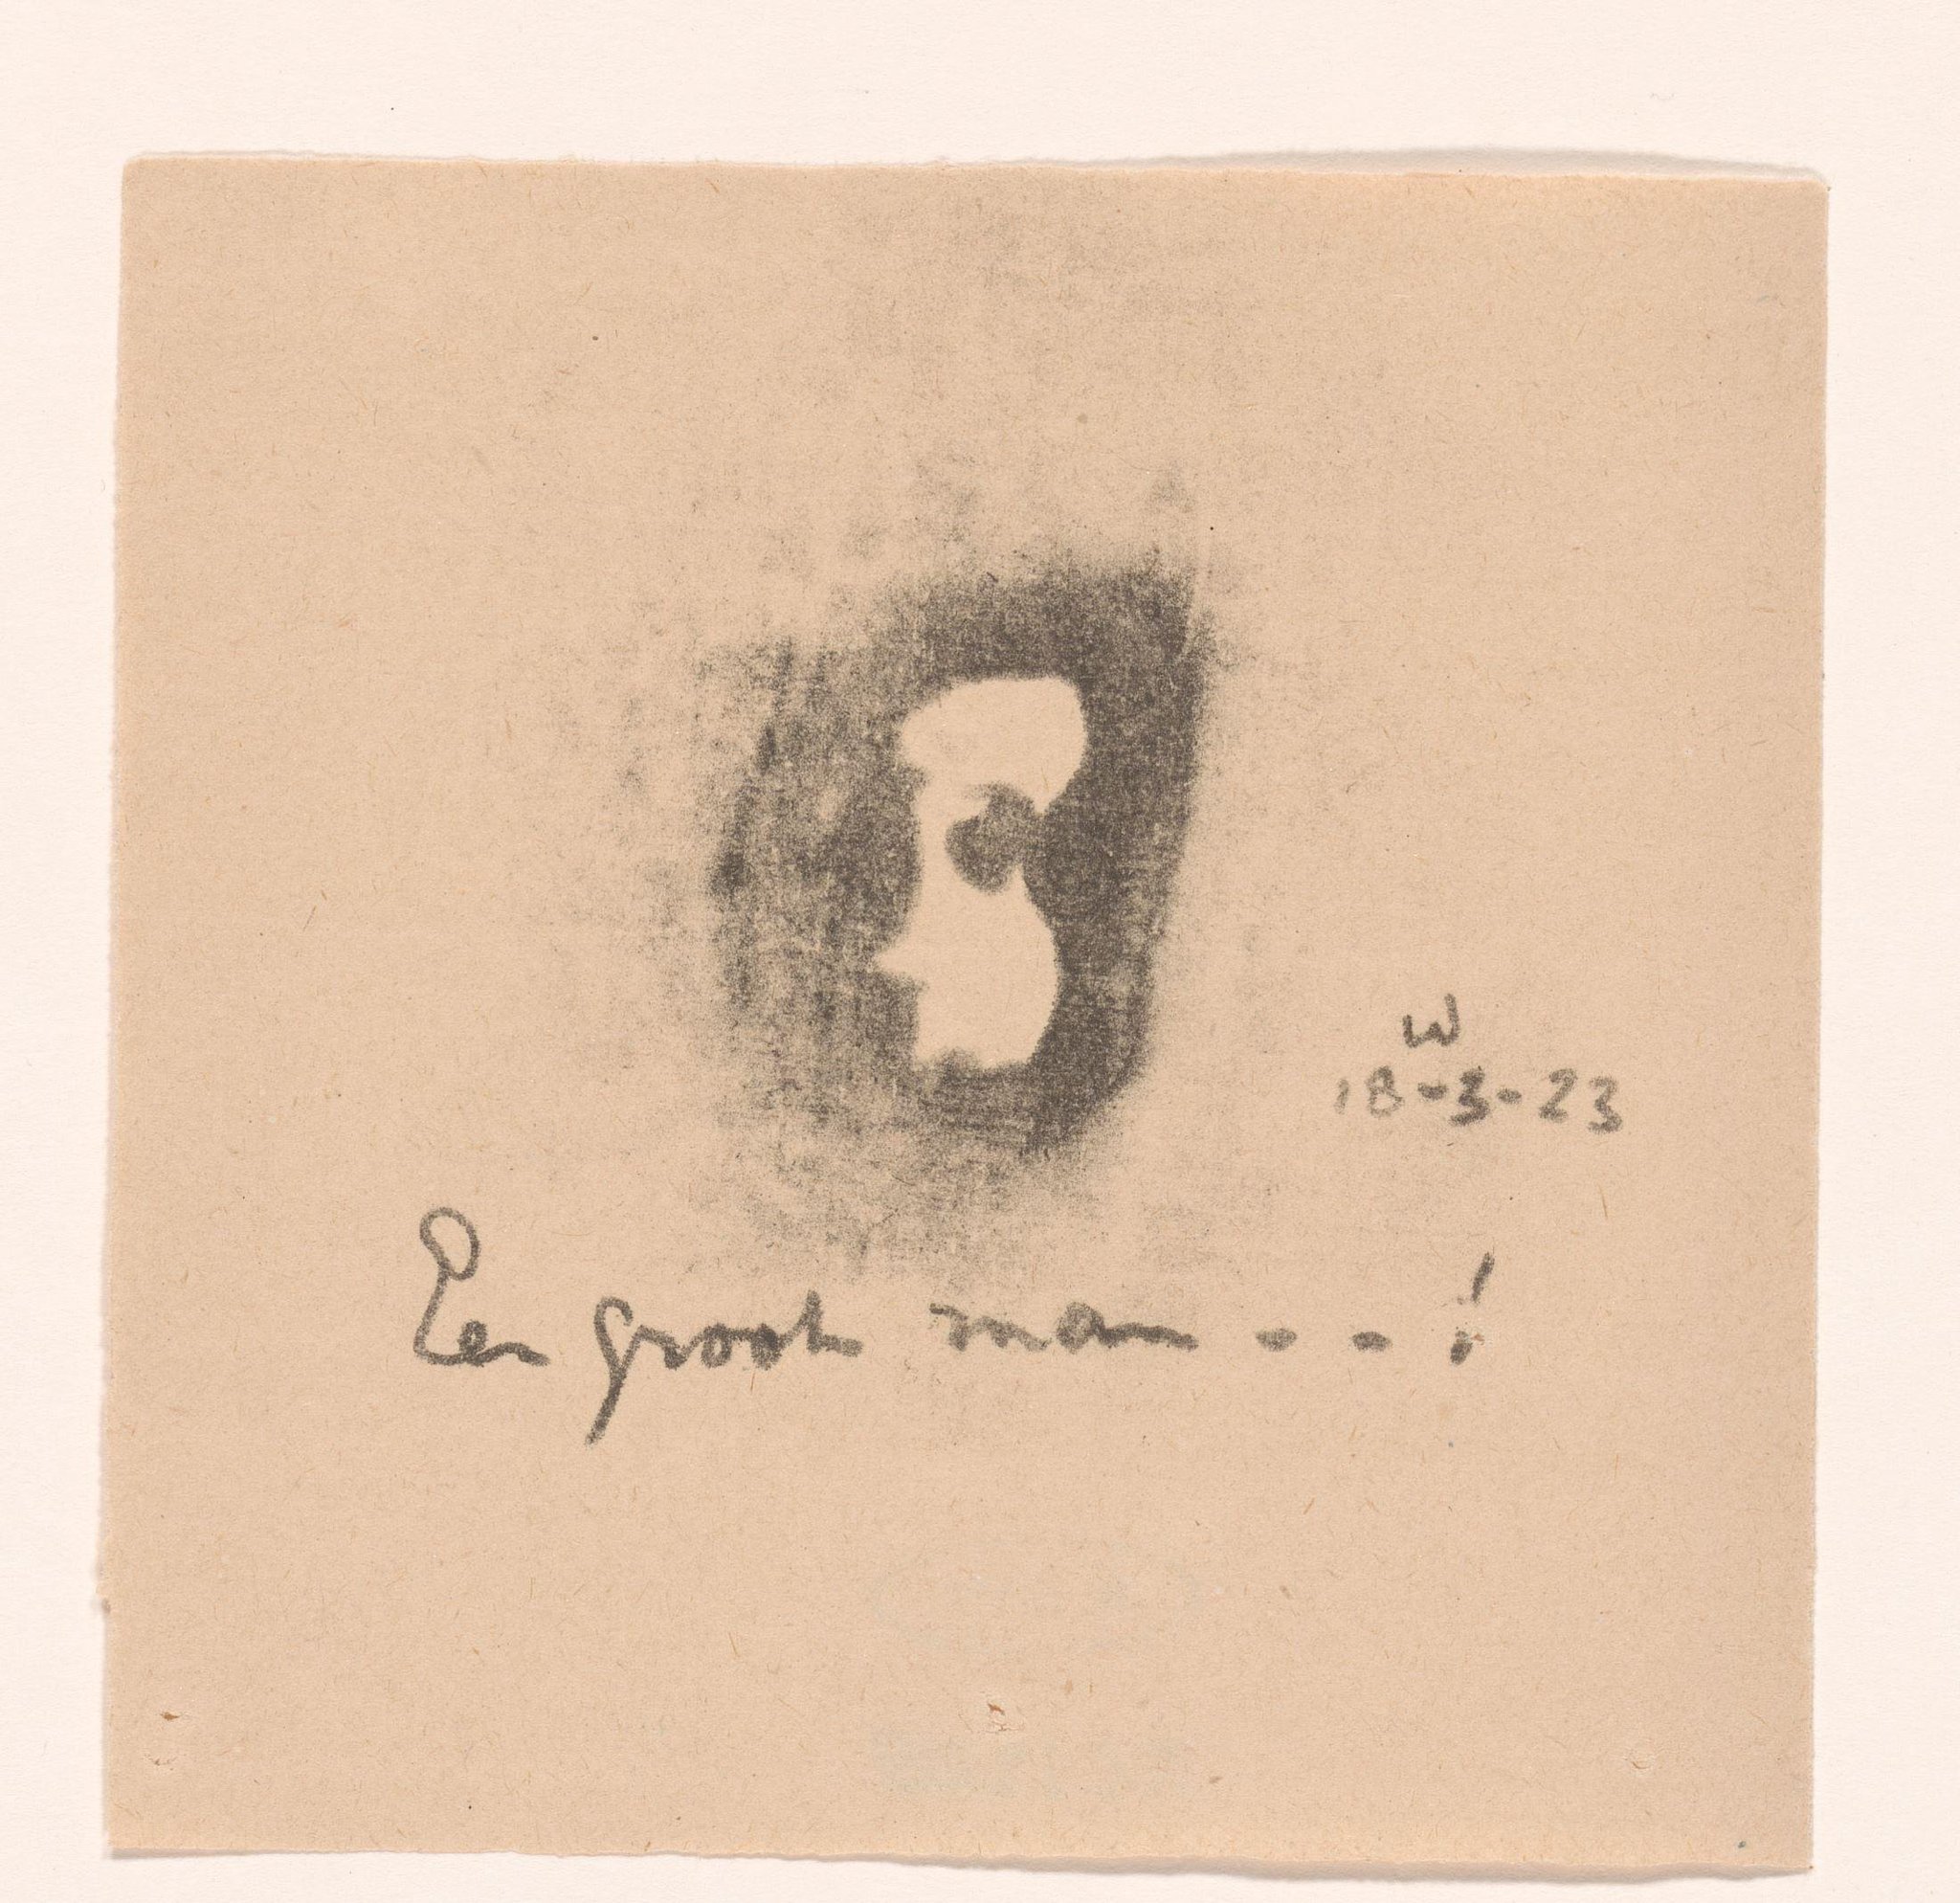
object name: print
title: Een groot man..!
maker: erich wichmann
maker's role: print maker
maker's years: 1890-1929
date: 1923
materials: paper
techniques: lithograph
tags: caricatures (human types)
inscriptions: collector's mark: Lugt 2228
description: Abstracte vorm, mogelijk de contouren van een gezicht.